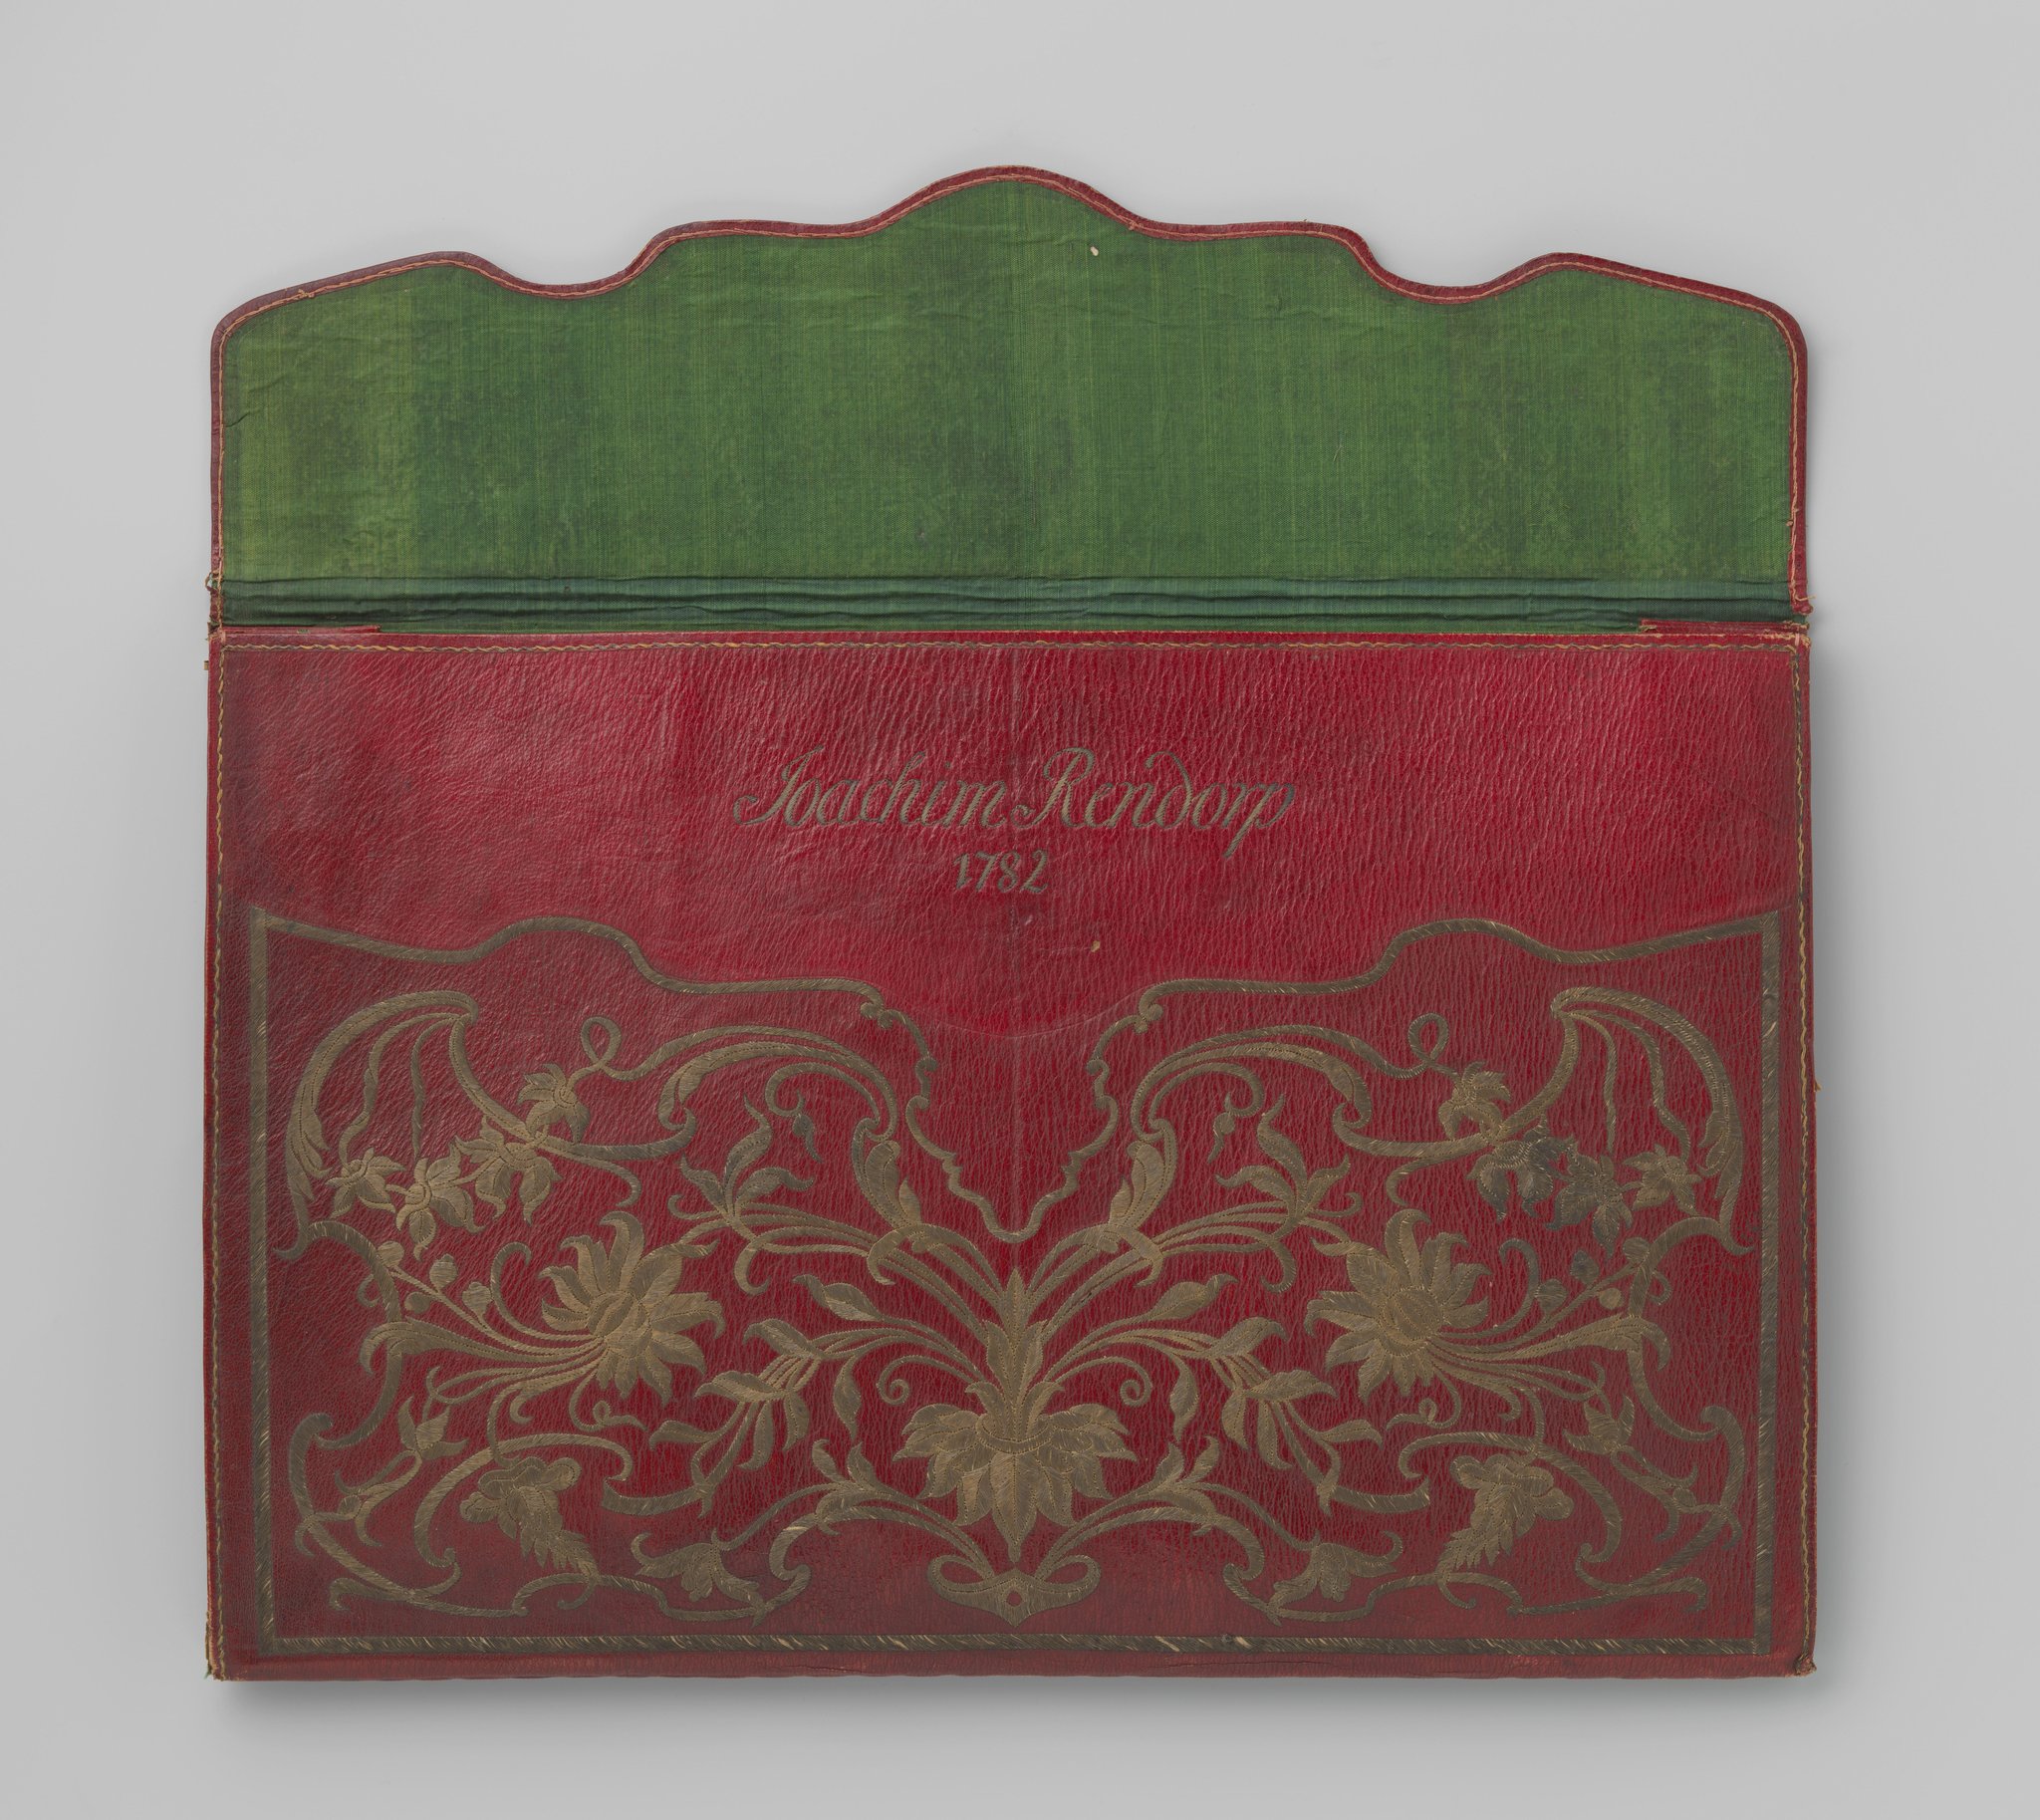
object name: brieventas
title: Brieventas Joachim Rendorp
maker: Anonymous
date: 1782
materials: gold thread, leather, thread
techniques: embroidered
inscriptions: inscription: ‘Familiewapen Rendorp’, inscription: ‘JOACHIM RENDORP 1782’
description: Joachim Rendorp (1728-1792) was directeur van de Societeit van Suriname, schepen, commissaris van de Hollandse rekenkamer, lid van de Admiraliteit van Amsterdam en burgemeester van Amsterdam, advocaat en diplomaat.